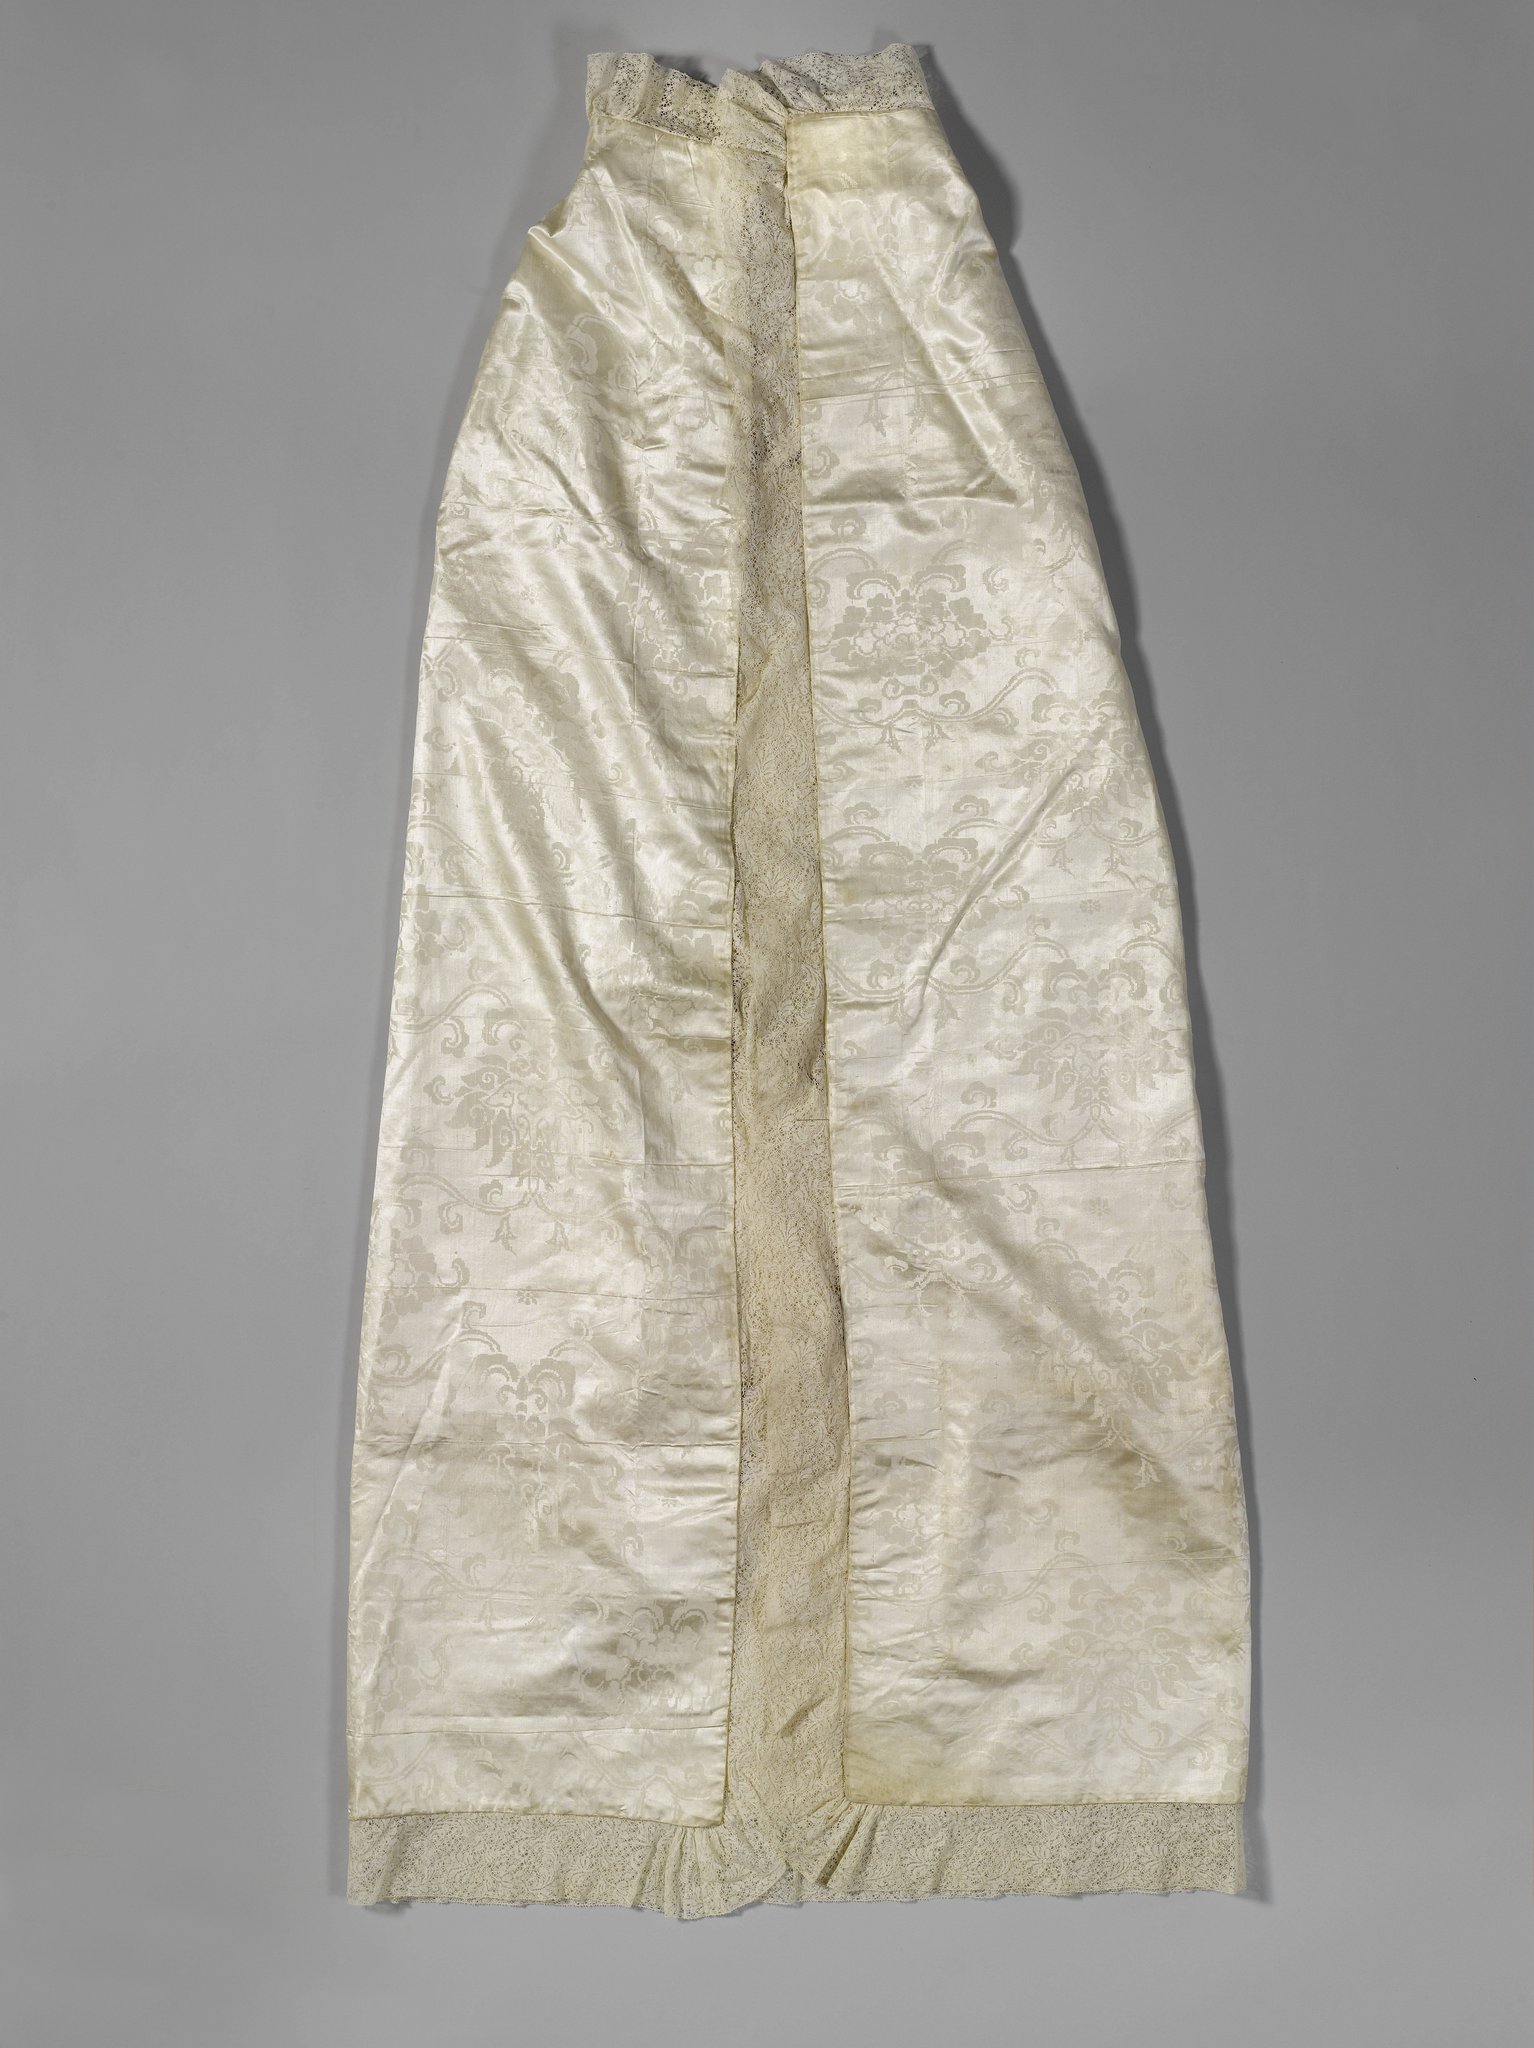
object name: doopkleed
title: Doopkleed van zijde damast met rijen bloemen verbonden met accolades en rondom afgewerkt met een strook kloskant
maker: Anonymous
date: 1725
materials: linen, silk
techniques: lace, damask, weave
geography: binche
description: Doopkleed van crèmekleurige zijdedamast, met een patroon van en rondom afgewerkt met een strook naturelkleurige kloskant: Binche-kant. Rechthoekig model waarbij één kant sterk is gerimpeld. Het kleed is gevoerd met effen crèmekleurige zijde. Damast: het zich herhalende patroon bestaat uit rijen bloemen die met accolade-ranken met elkaar verbonden zijn. Er zijn twee soorten bloemen, per rij één soort. Kant: het zich herhalende patroon bestaat uit een rivière van gevederde bladvoluten met bloemen en palmetten. De motieven zijn grotendeels gemaakt in linnenslag met opengewerkte randjes en in enkele bladeren en bloemen is netslag toegepast. De motieven zijn met elkaar verbonden door een geringde sneeuwvlokkengrond. De strook is glad aan het damast gezet, met uitzondering van de hoeken waar de strook kant om het damast is geplooid. De onderzijde (buitenzijde) van de strook kant is recht afgewerkt met picots.